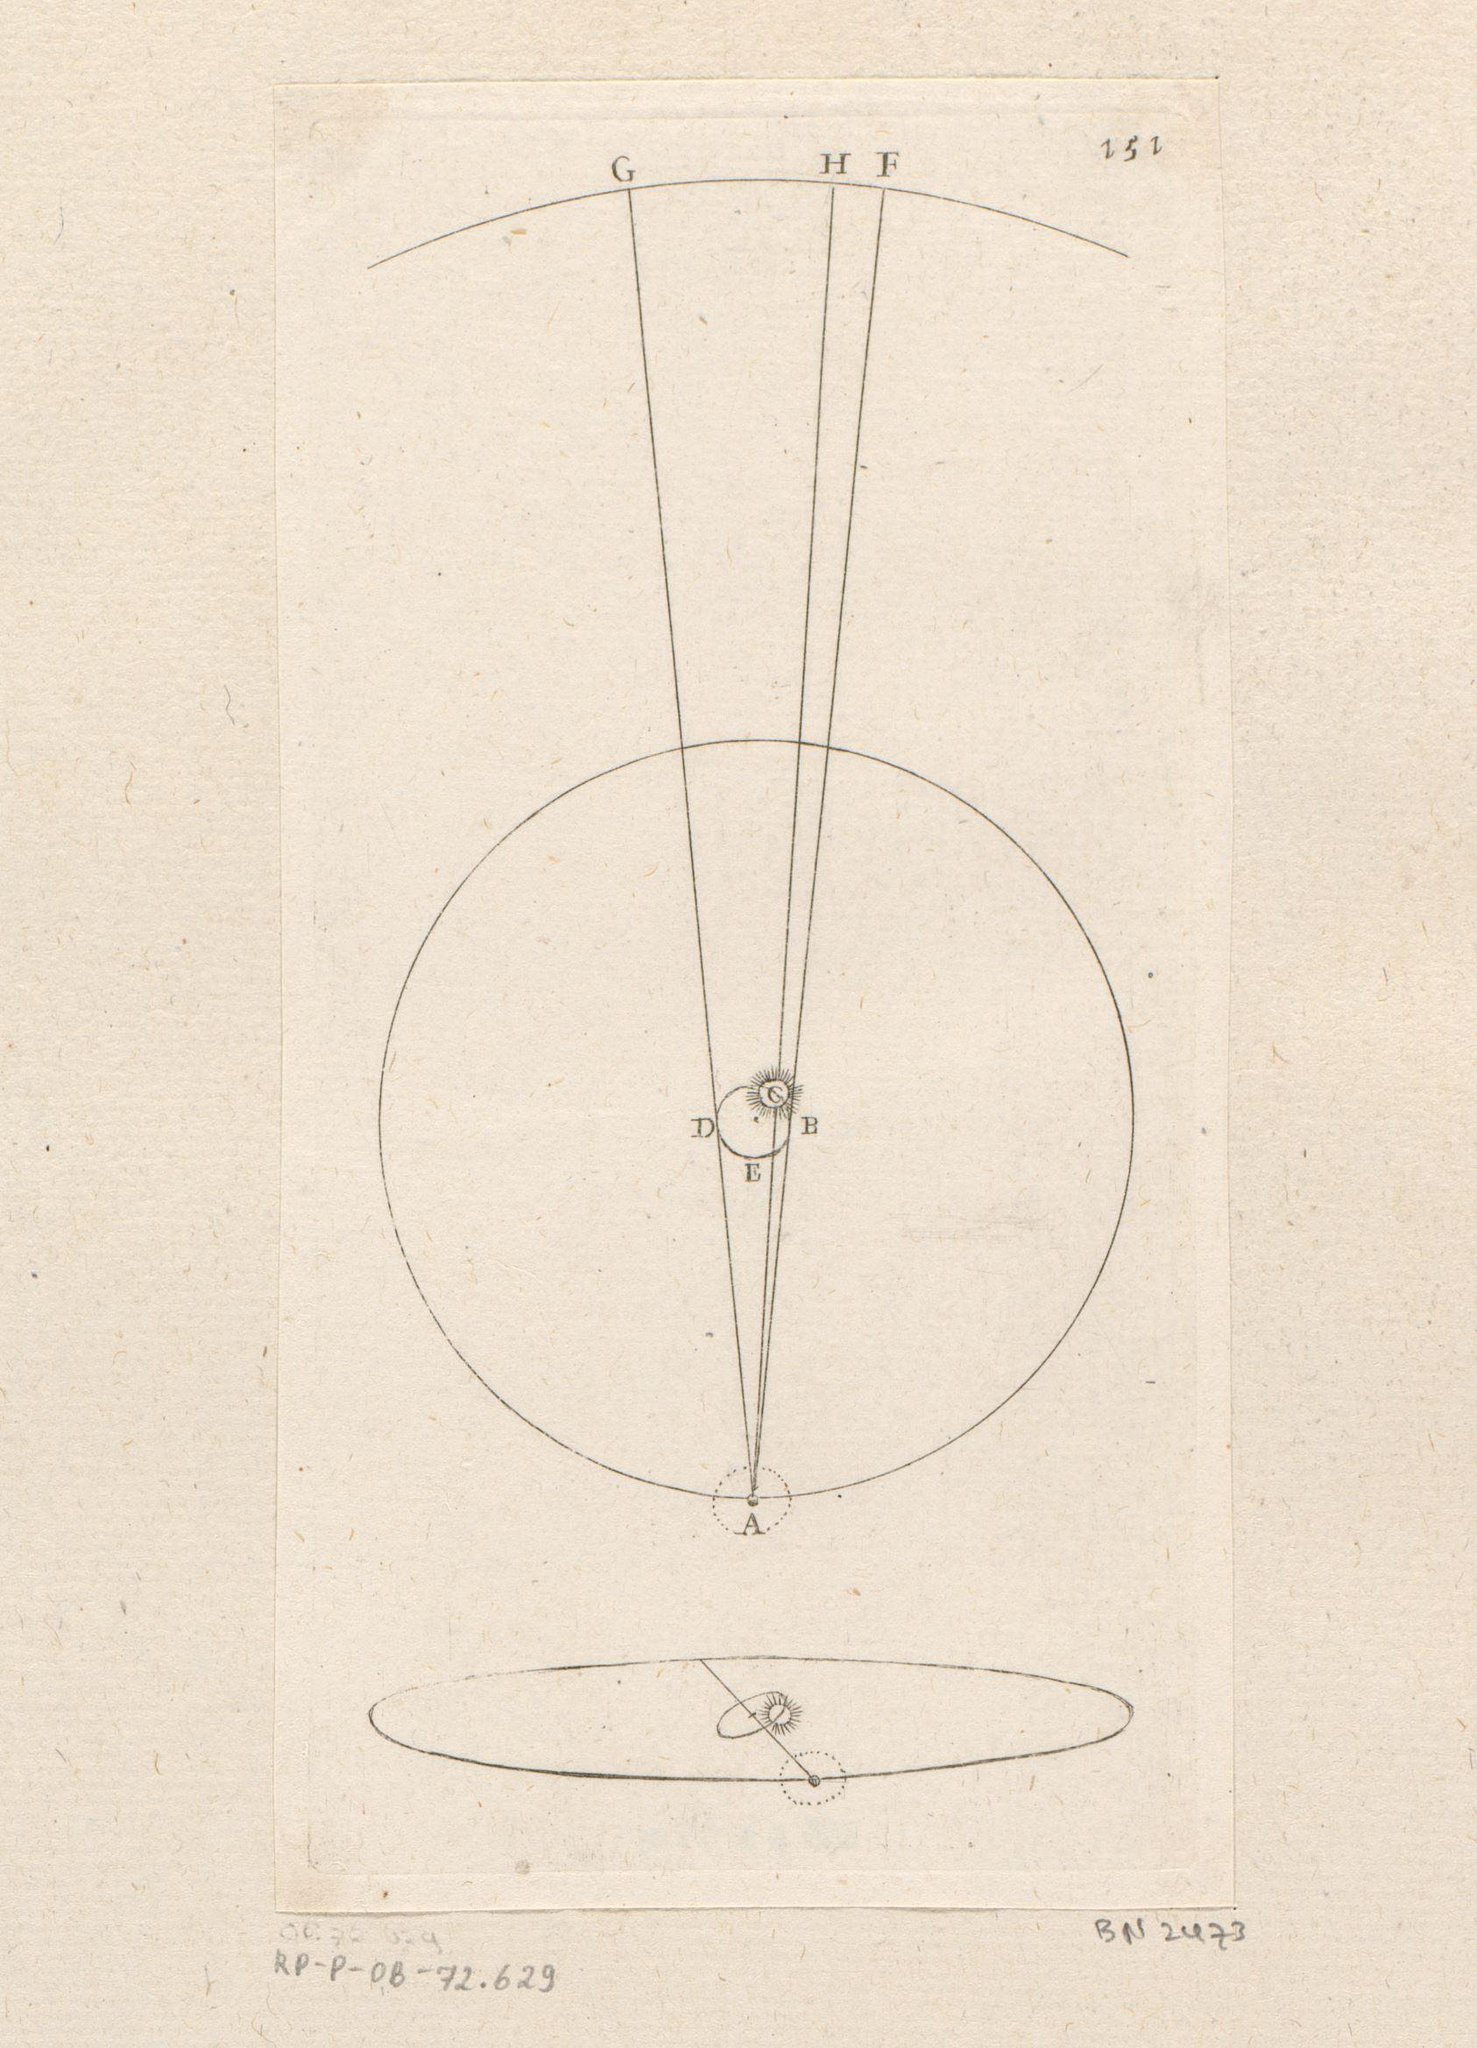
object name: print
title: Verhouding Aarde tot de Zon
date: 1706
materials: paper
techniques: etching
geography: france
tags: earth, world as celestial body, sun as celestial body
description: Prent uit: Leclerc, Sébastien. Nouveau systeme du monde conforme à l'Ecriture sainte. Où les phénomènes sont expliquez sans excentricité de mouvement (...). Paris: Pierre Giffart, 1706.